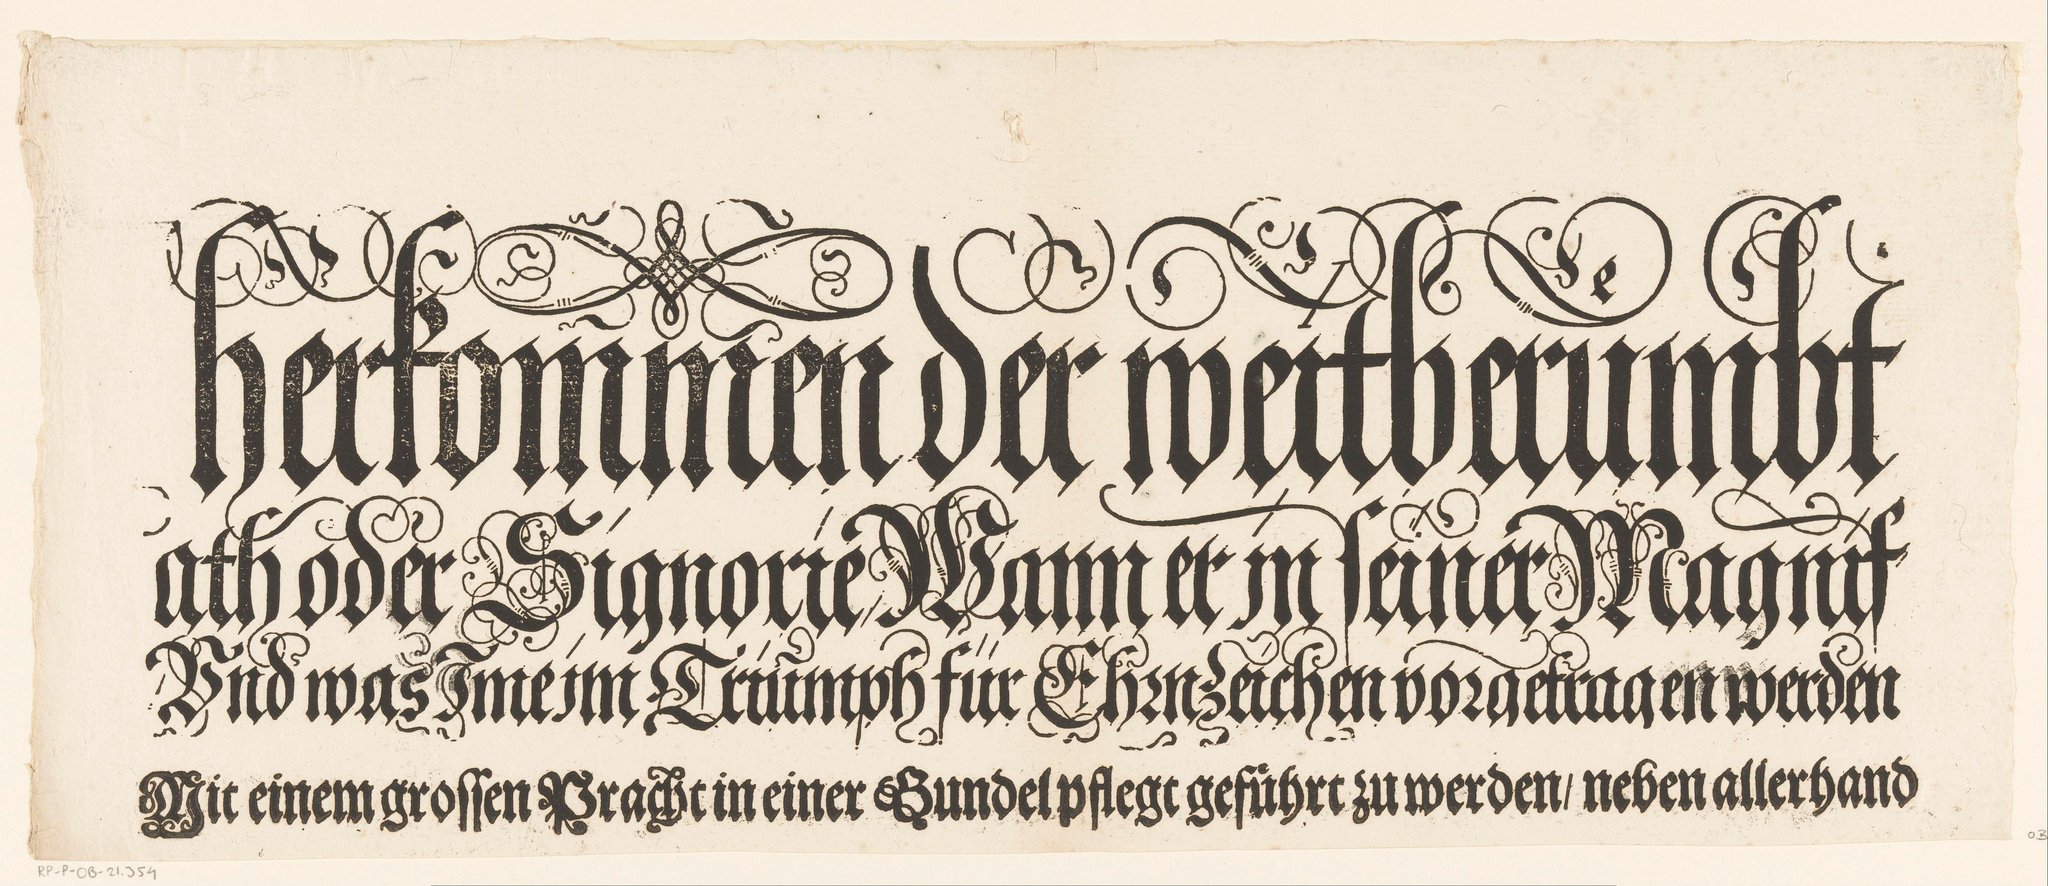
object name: text sheet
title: Titel van de Festa della Sensa (tweede gedeelte)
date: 1697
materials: paper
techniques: woodcut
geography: nuremberg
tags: city-view in general; 'veduta', procession ~ christian religion, gondola, venice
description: Tweede gedeelte van een titel behorende bij een prent van de Festa della Sensa. De voorstelling is gedrukt van veertien blokken, de titel van vijf blokken en het onderschrift bestaat uit vijf delen van elk drie kolommen Duits tekst. In de collectie Rijksmuseum bevinden zich twee complete exemplaren inclusief titel en onderschrift. Omdat niet alle delen van de titel en het onderschrift op afzonderlijke bladen zijn gedrukt, is dit exemplaar niet virtueel samengevoegd omwille van een betere presentatie. Zie voor het andere exemplaar: RP-P-2017-6073.